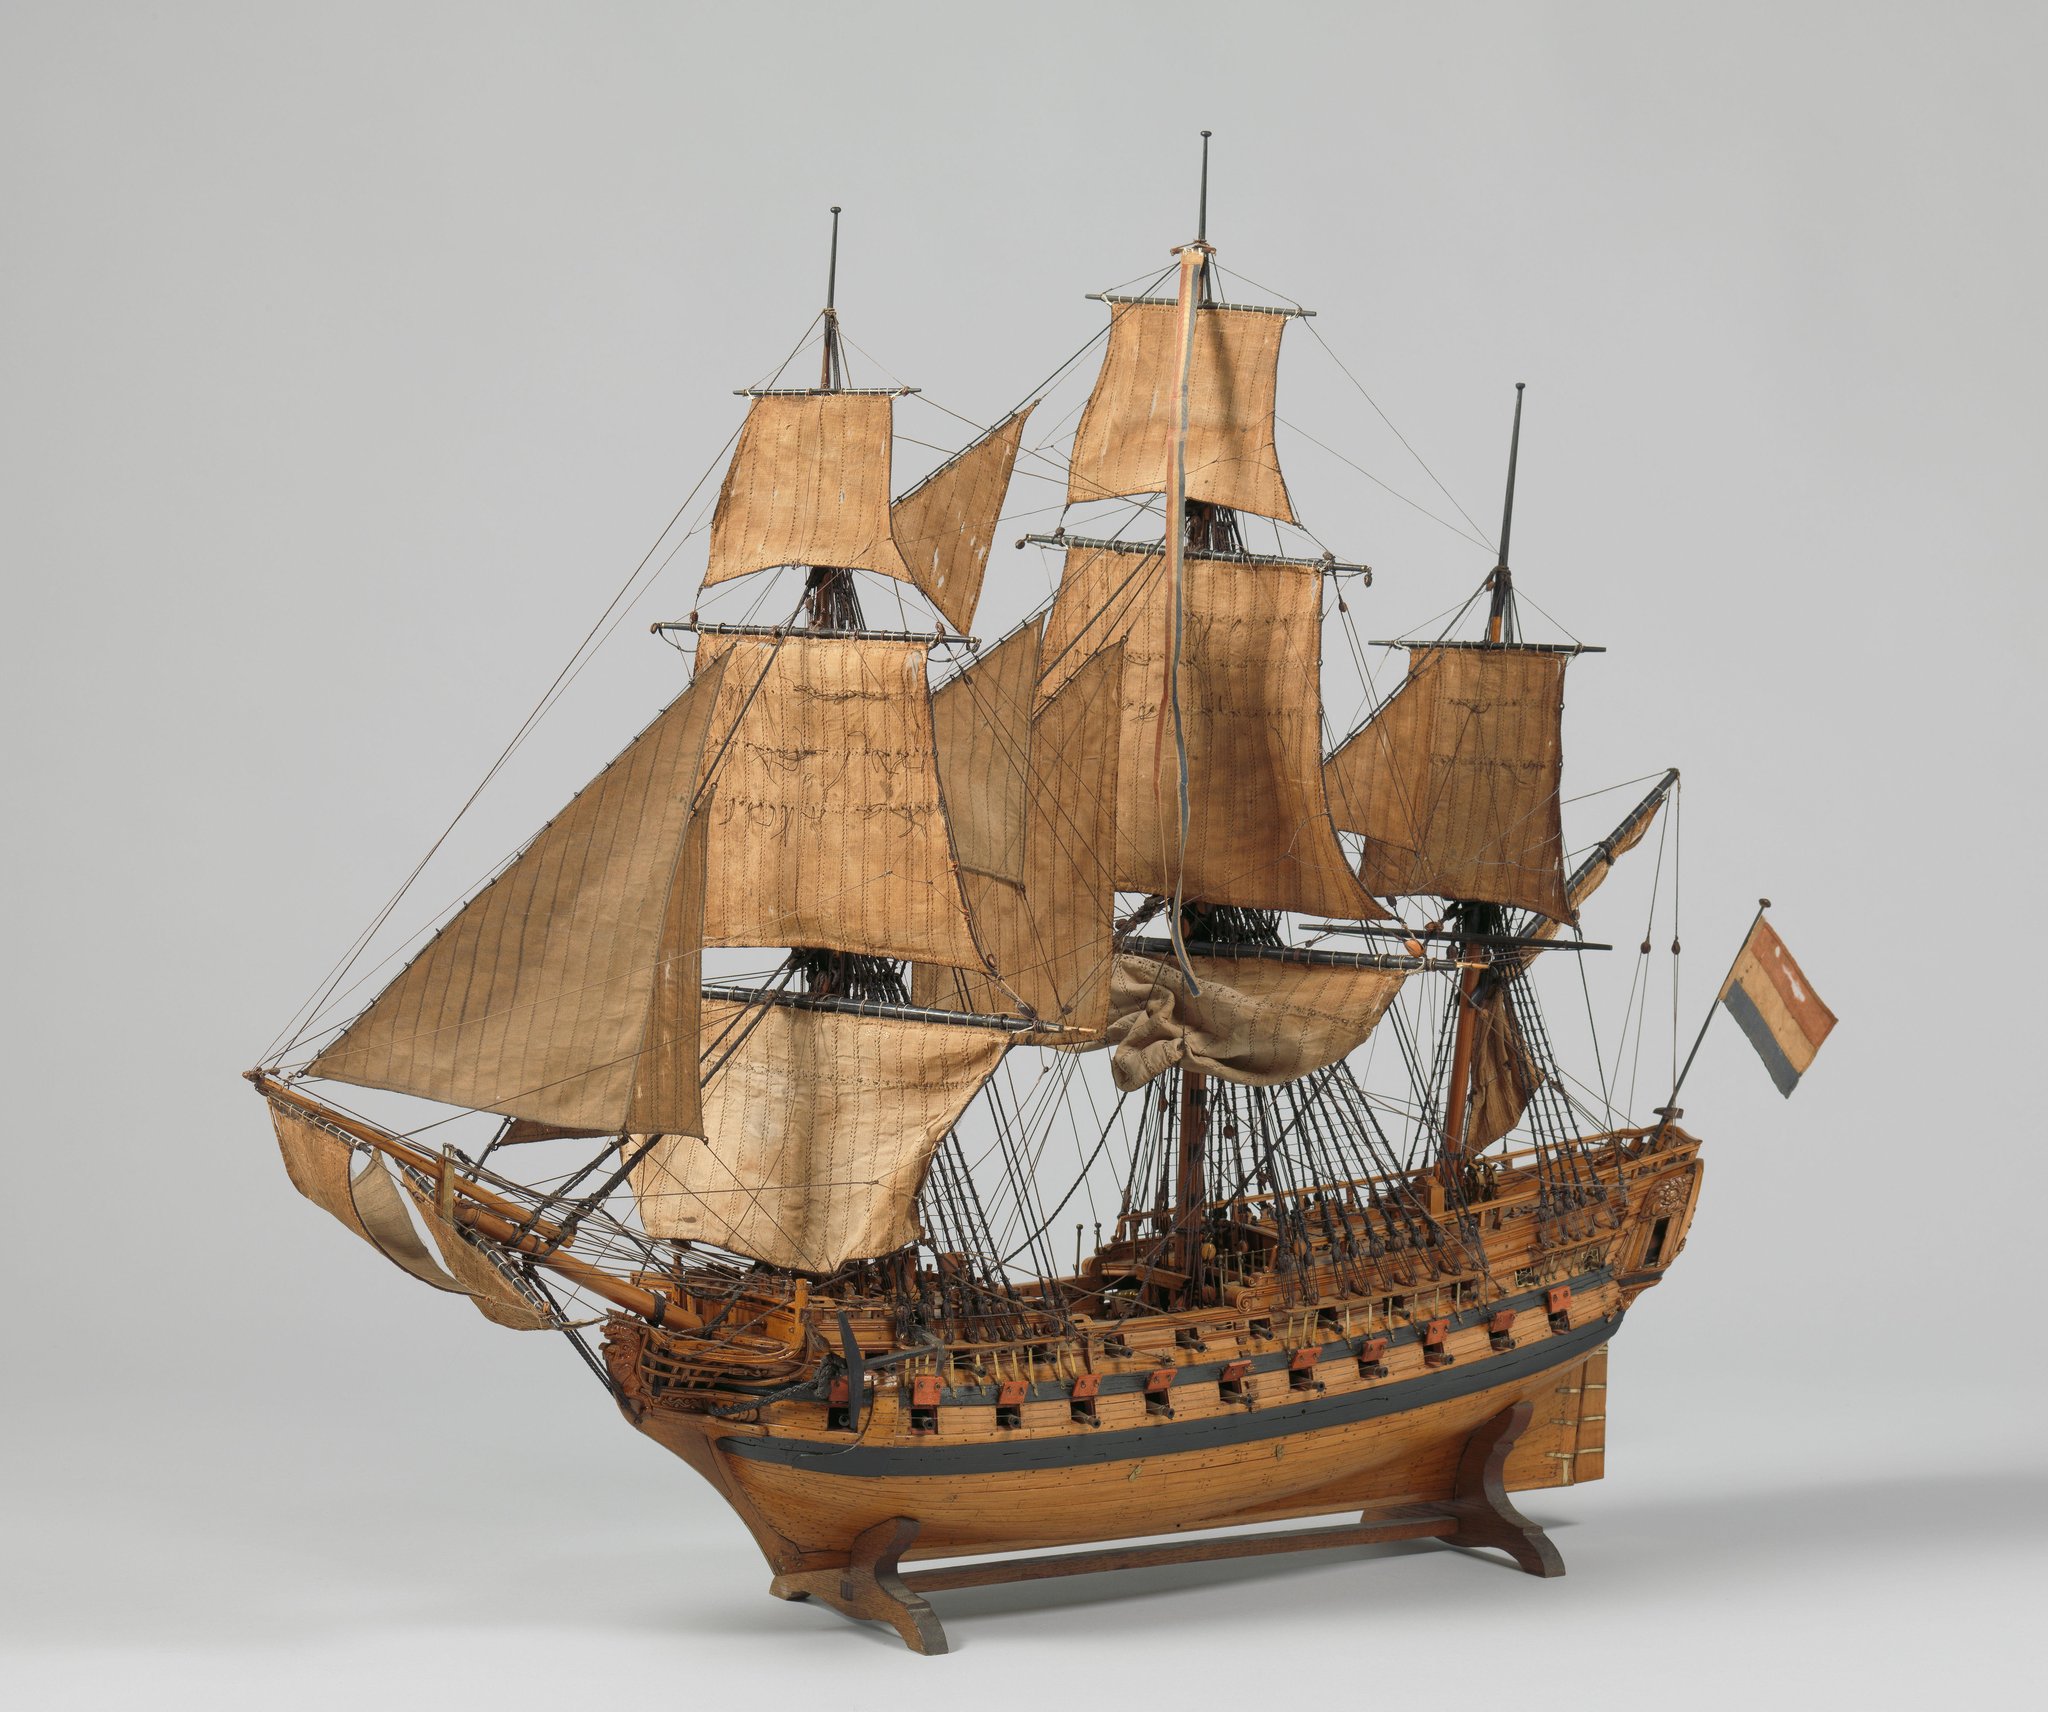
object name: fully rigged model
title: Model of a 44-Gun Ship of the Line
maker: lucas de waal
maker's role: model maker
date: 1784-1799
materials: brass, ivory, fiber, textile, wood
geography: amsterdam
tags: ship-model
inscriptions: inscription, on the stern: ‘HECTOR’